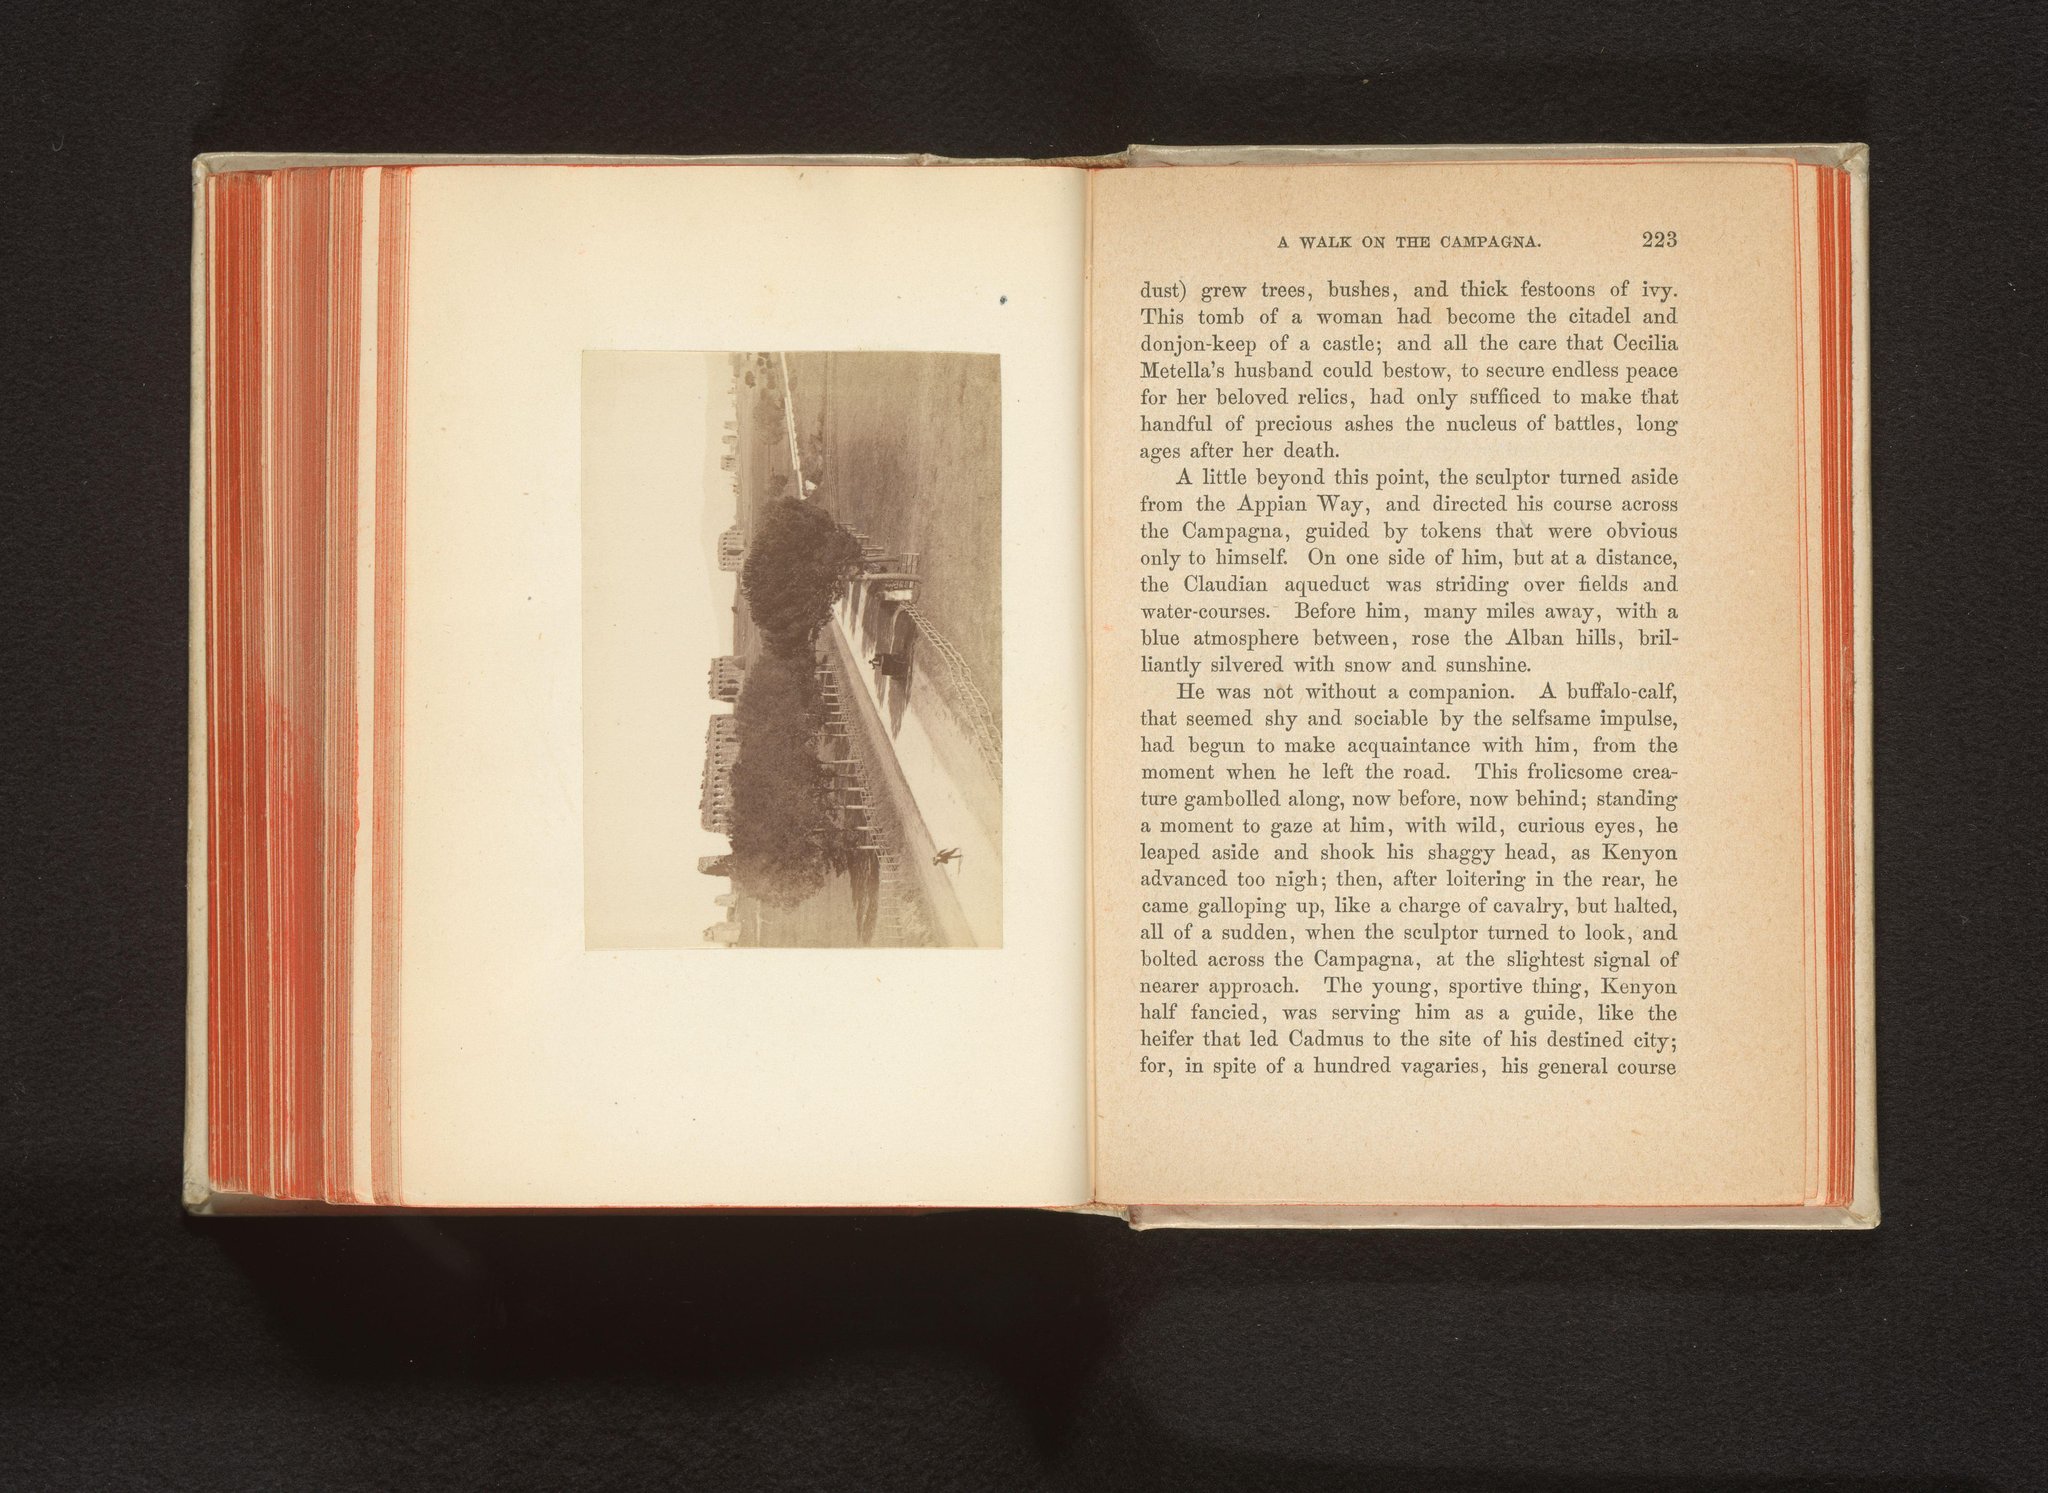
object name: photograph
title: Gezicht op de Via Appia bij Rome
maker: Anonymous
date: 1850-1860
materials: photographic support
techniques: albumen print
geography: rome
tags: landscape with ruins, street